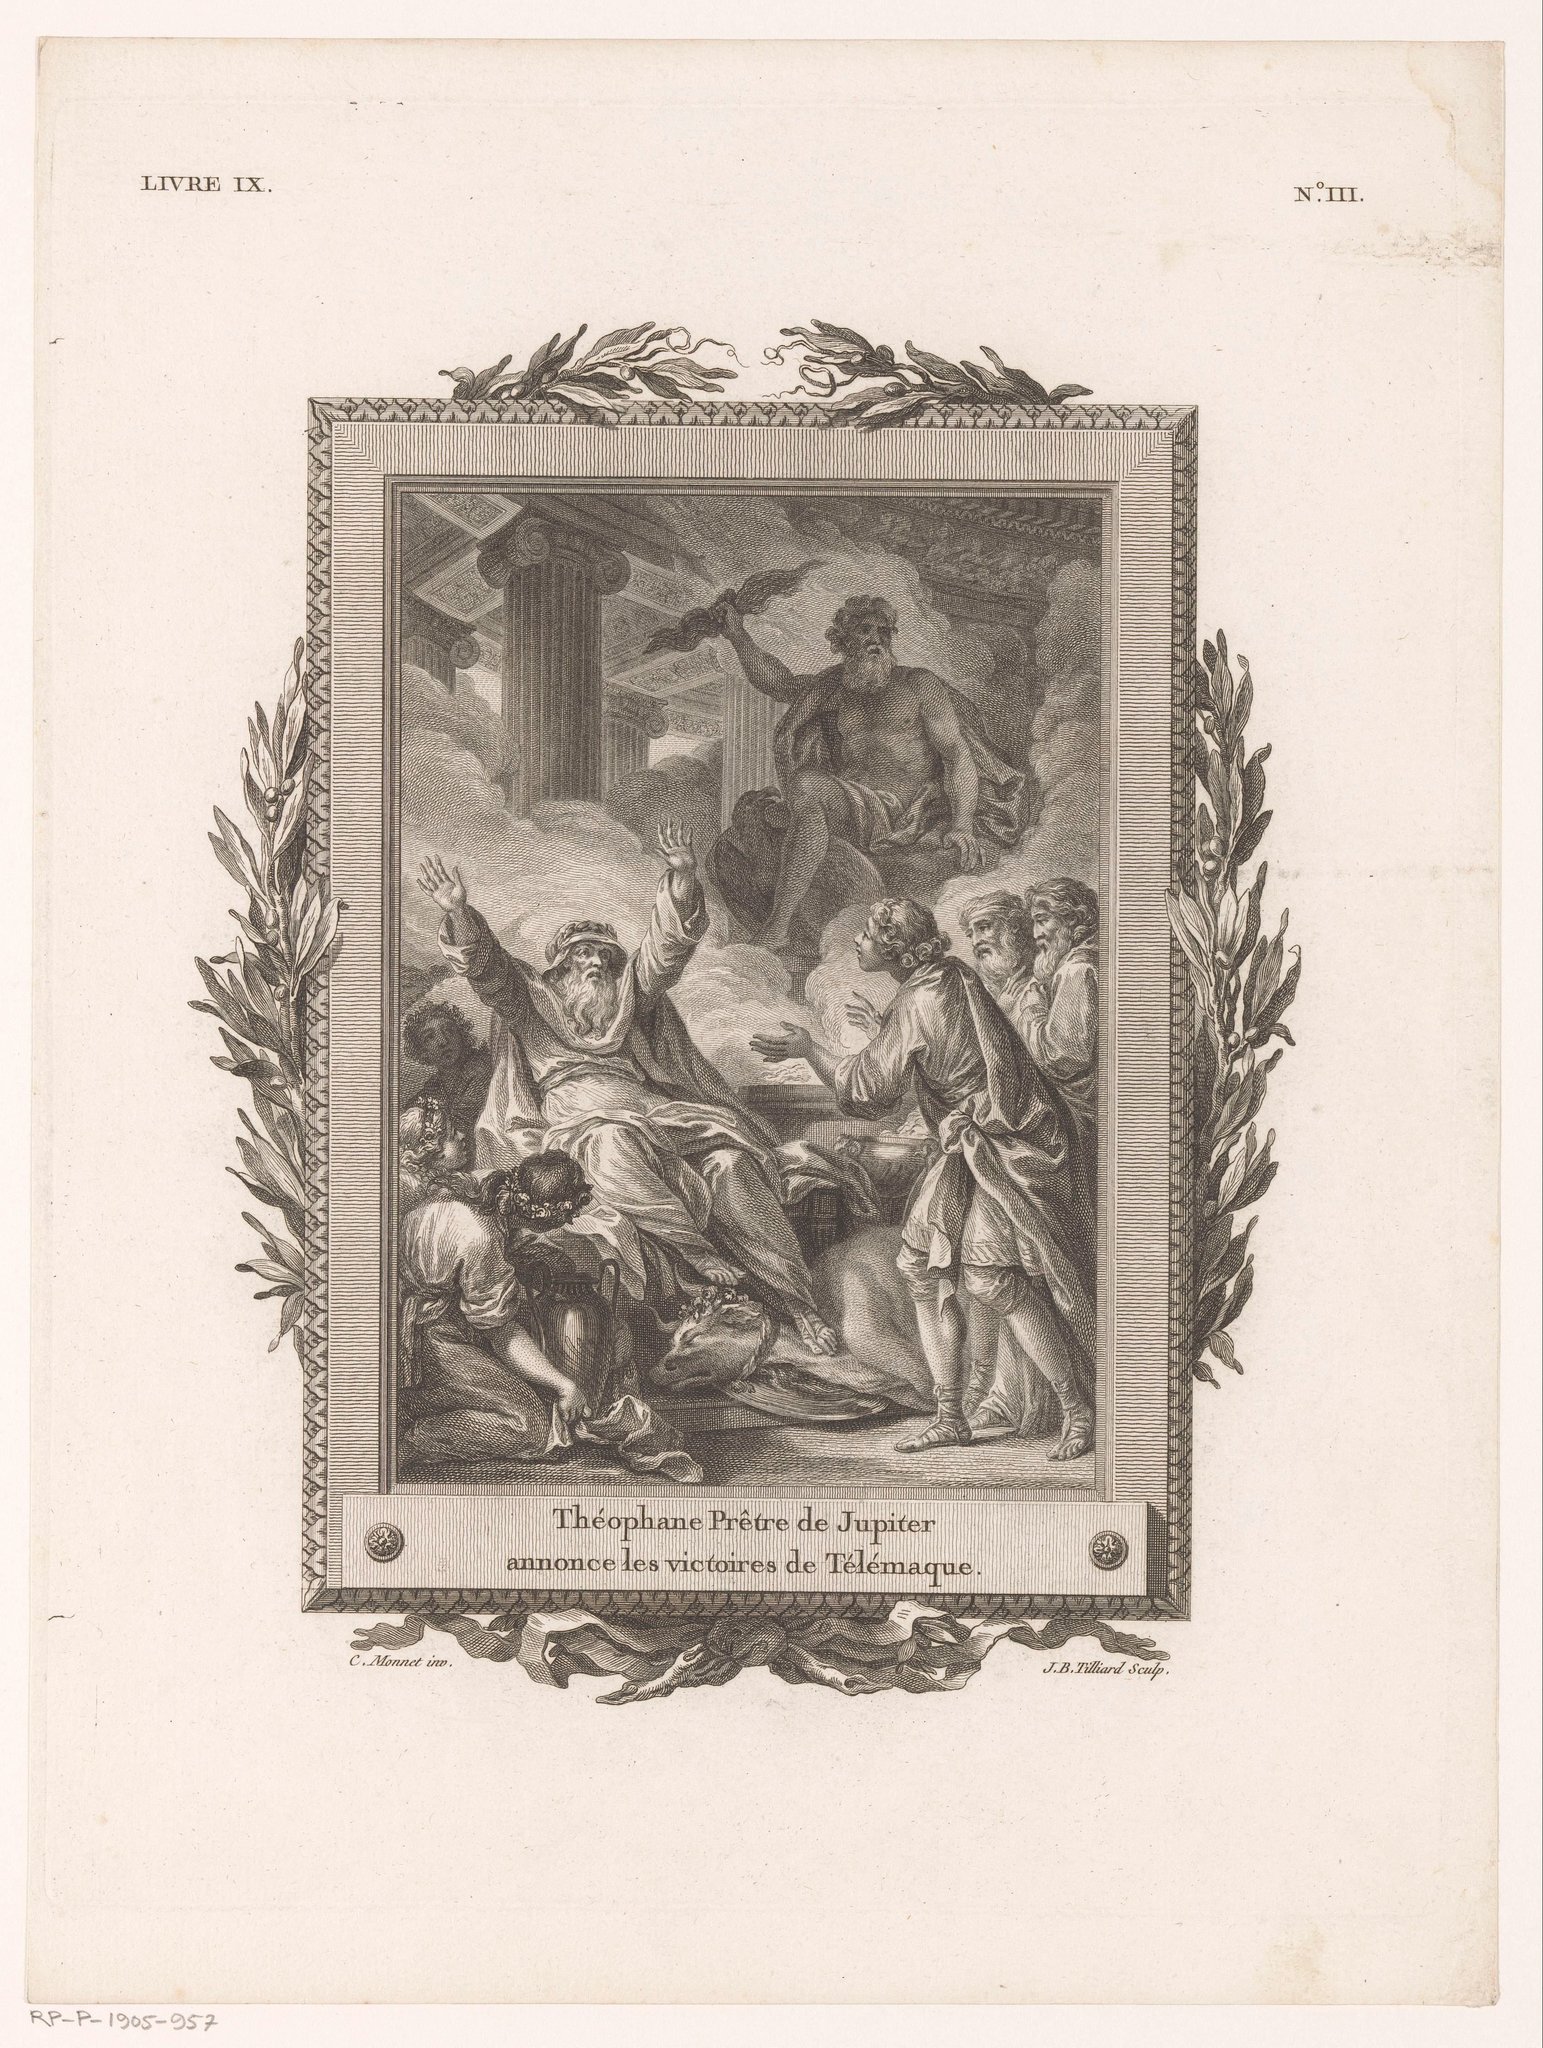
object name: print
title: Theophanes kondigt de overwinningen van Telemachus aan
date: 1785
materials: paper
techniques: engraving, etching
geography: france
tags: (fenelon, telemachus) specific works of literature (with author, title), visions of the future, (story of) telemachus, ornament ~ festoon, garland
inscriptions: collector's mark: Lugt 2228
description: In een tempel met een standbeeld van Jupiter op de achtergrond kondigt Theophanes (links) met zijn handen omhoog gestoken, de overwinningen aan van Telemachus. Met zijn voeten steunt hij op een geofferde koe. Tegenover hem aan de rechterzijde bevinden zich Telemachus en Mentor. Het geheel wordt gekaderd door een sierlijst met olijftakken en onderaan een strik. Genummerd rechtsboven: No. III.